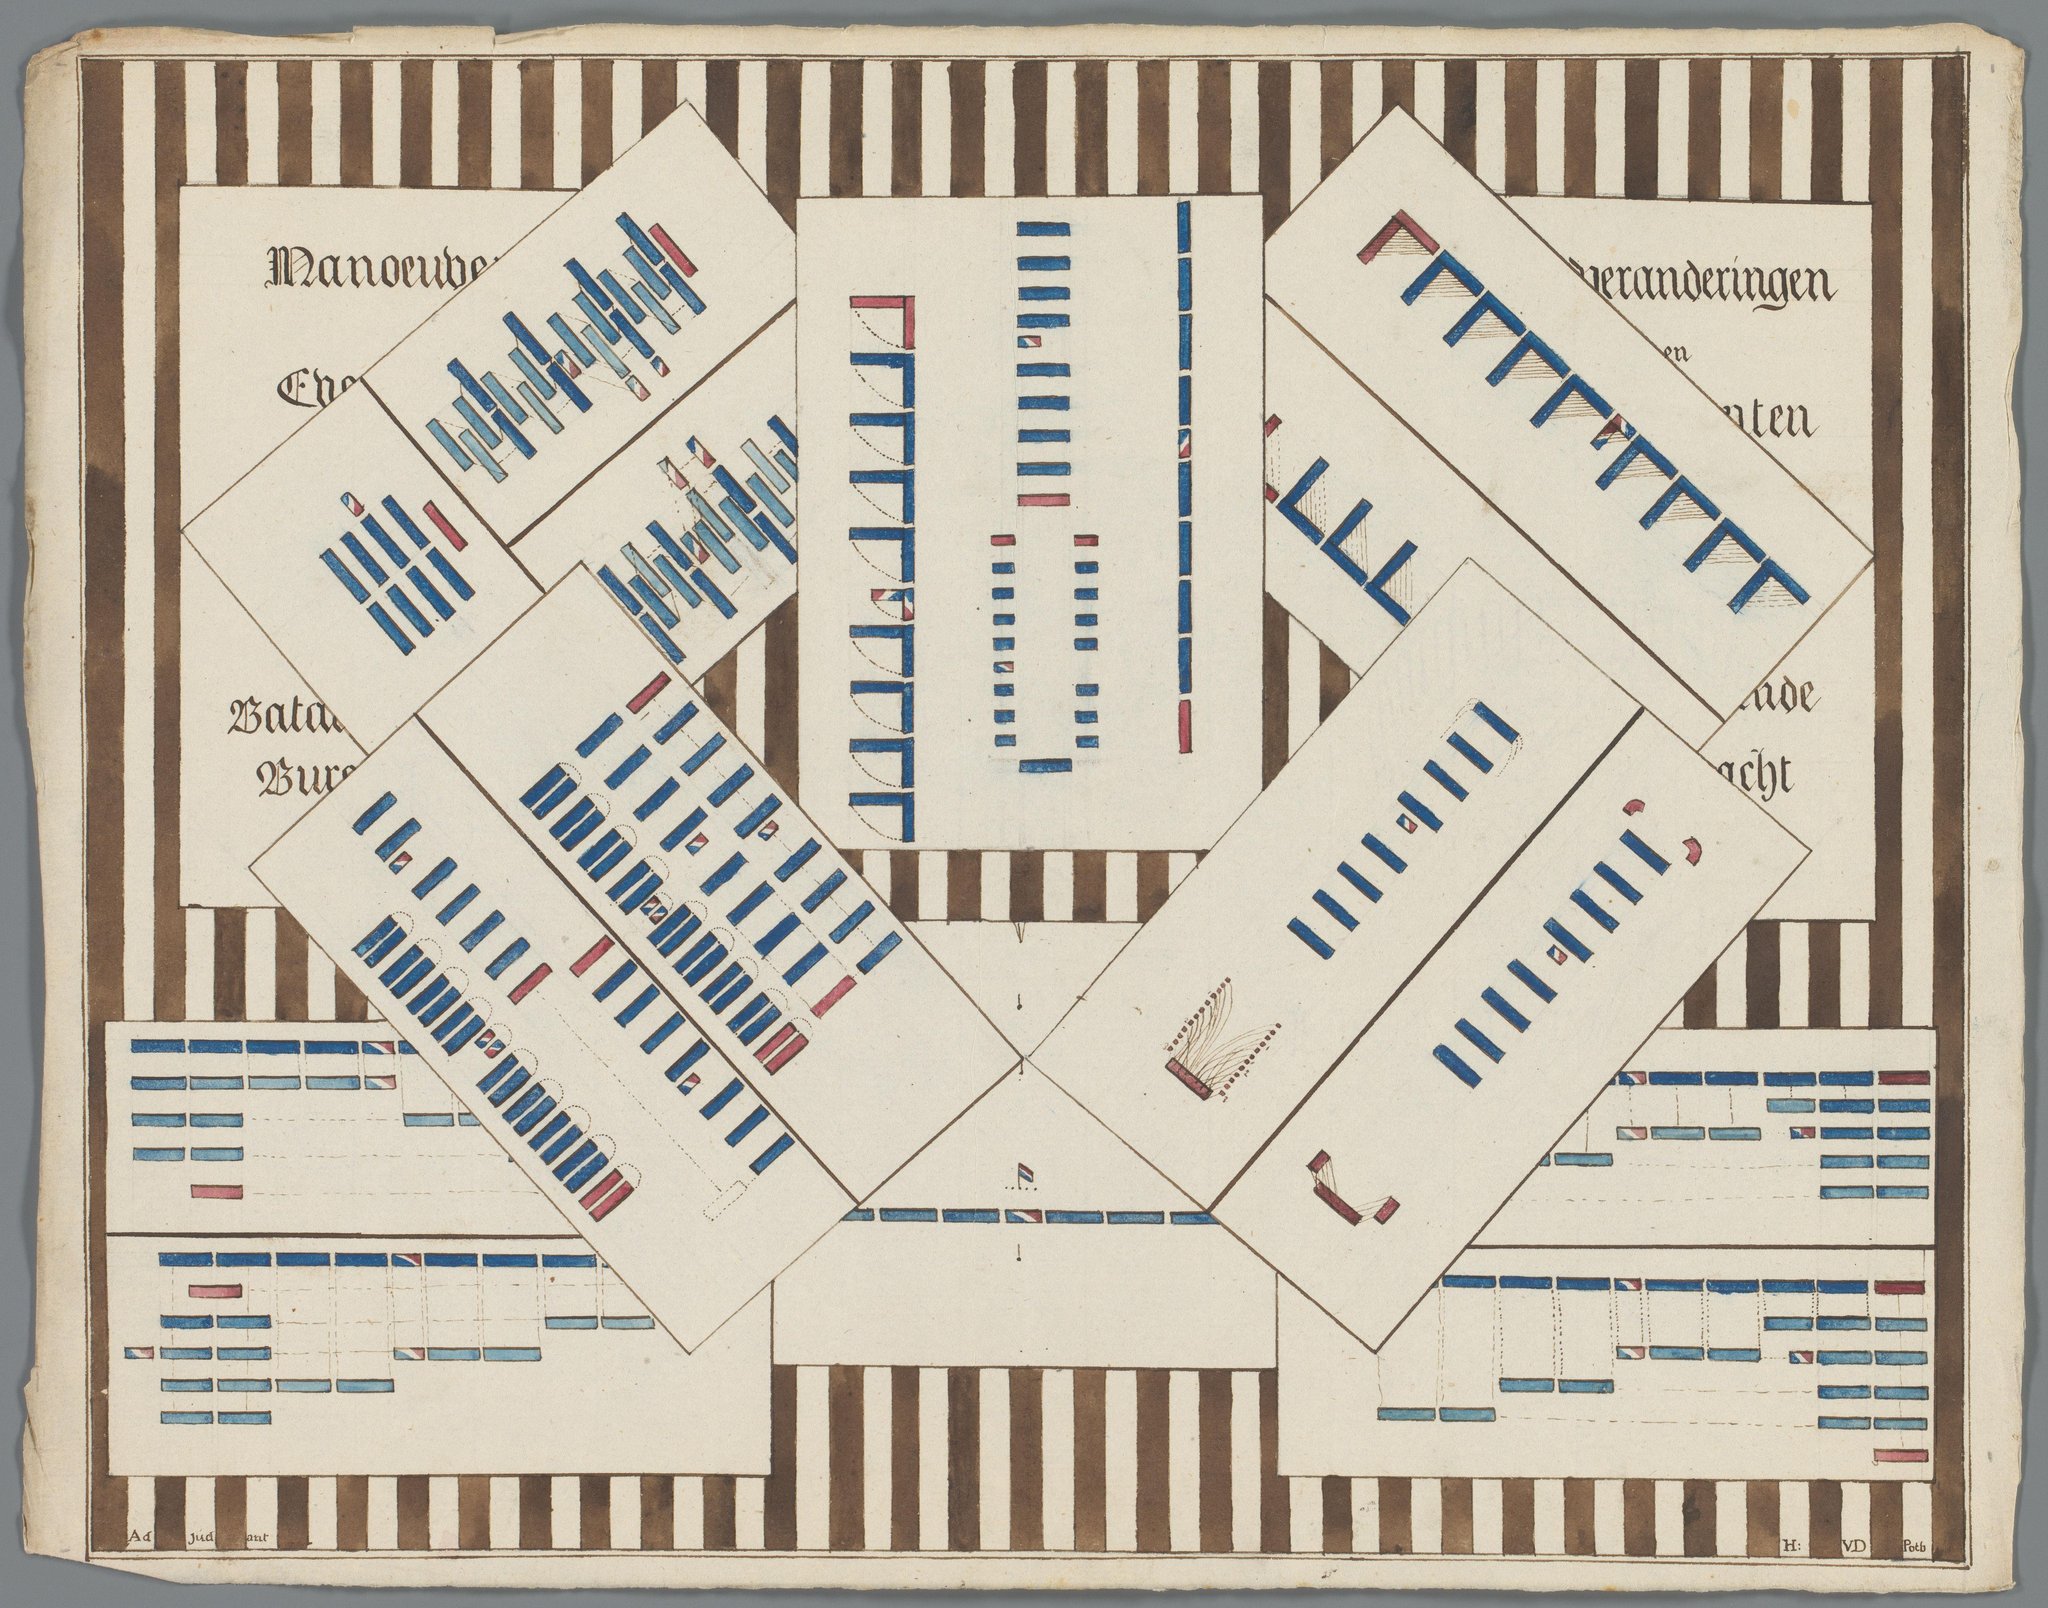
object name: drawing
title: Boerenbedrieger met bladen met manoeuvres, ca. 1798-1803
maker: hendrik van der poth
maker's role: draughtsman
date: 1798-1803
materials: paper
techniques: writing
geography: netherlands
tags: 'trompe l'oeil', manoeuvre ~ military training, delft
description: Boerenbedrieger of trompe-l'oeil bestaande uit tien bladen papier met plattegronden van manoeuvres van de Bataafsche Gewapende Burgermacht te Delft, ca. 1798-1803.